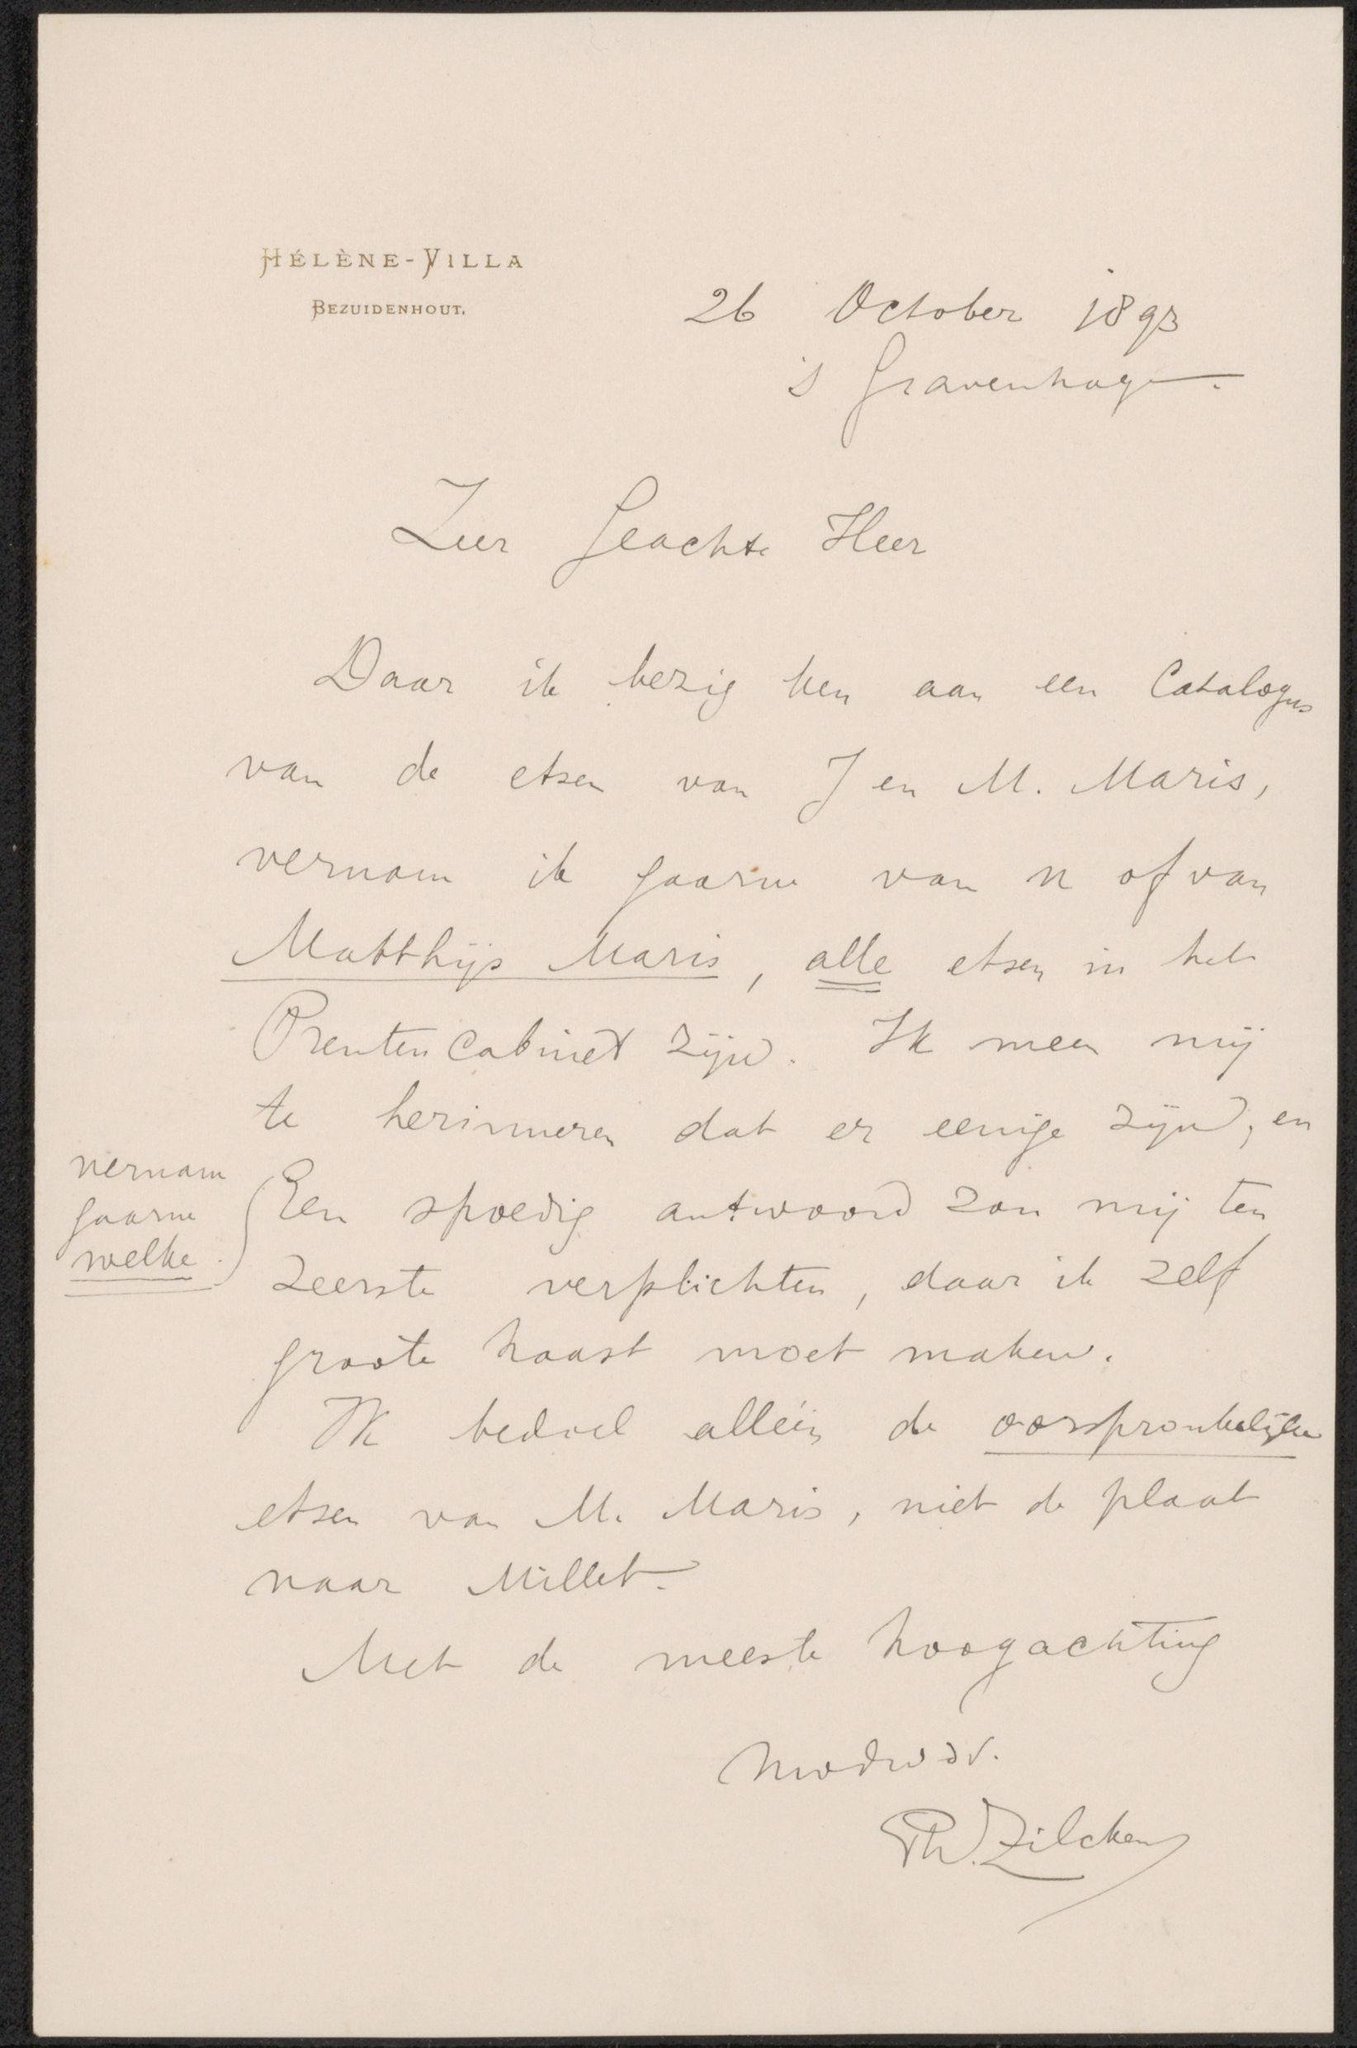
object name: letter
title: Brief aan Johan Philip van der Kellen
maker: philip zilcken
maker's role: draughtsman, painter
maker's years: 1857-1930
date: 1893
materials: ink, paper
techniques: pen, writing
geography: the hague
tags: utrecht, print maker, draughtsman, johan philip van der kellen, london, painter, matthijs maris, jacob maris, jean françois millet, the graphic arts